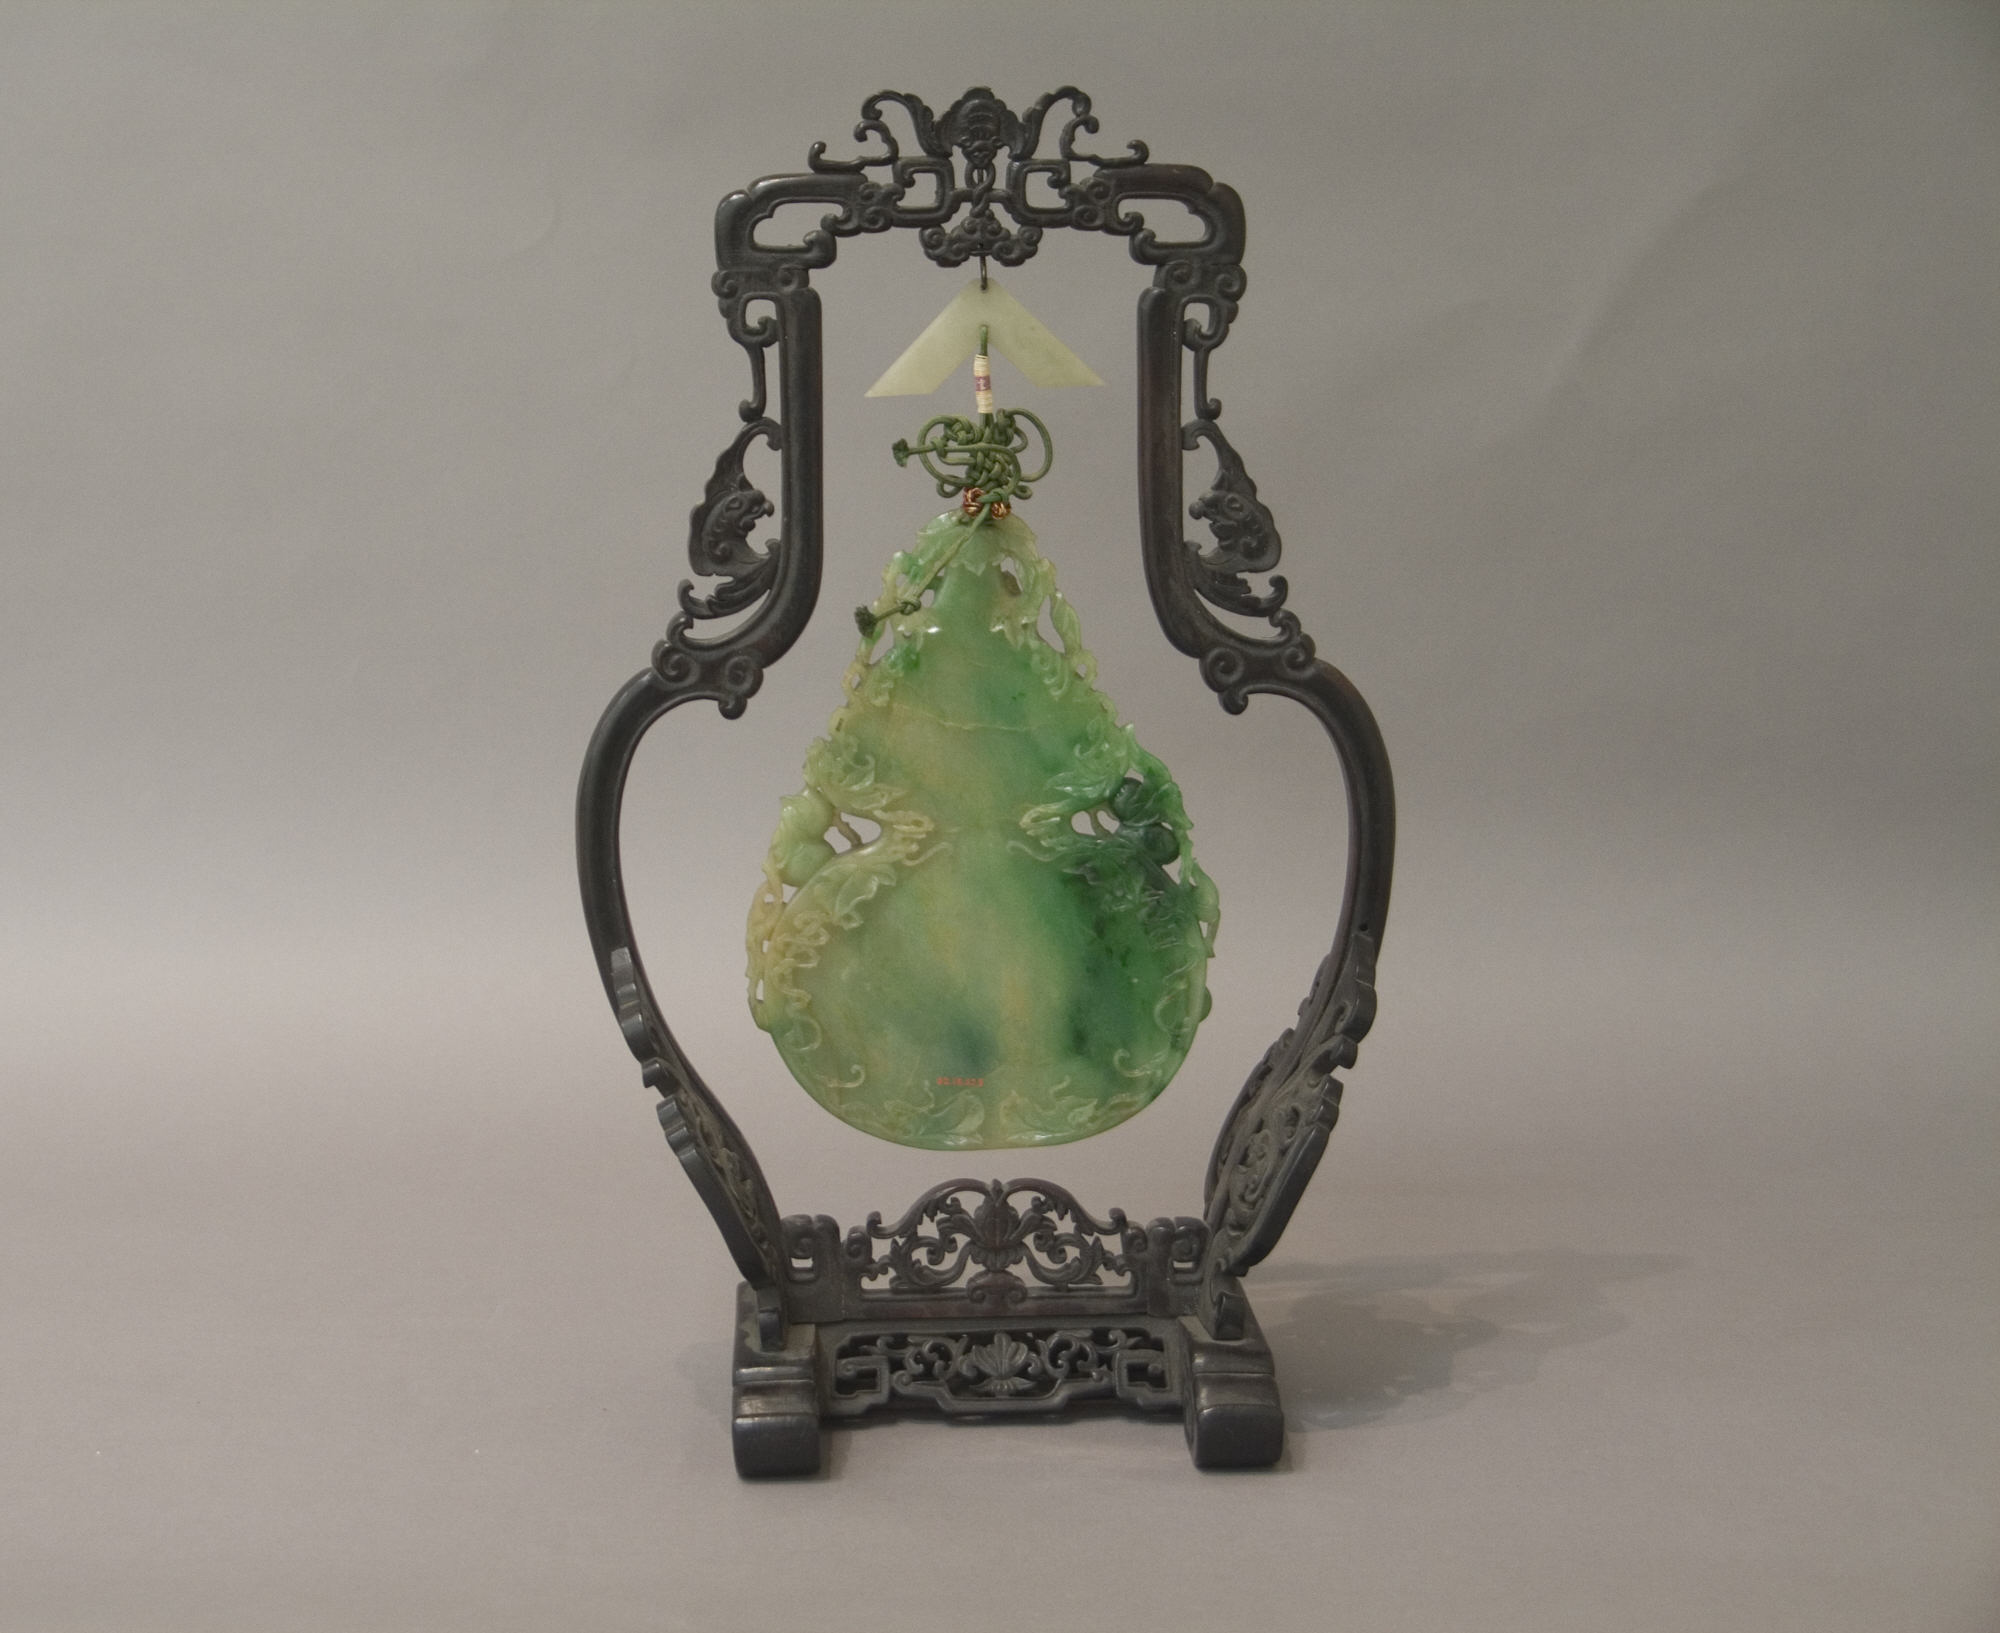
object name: ornament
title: Double gourd ornament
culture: chinese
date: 1801-1900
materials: jade